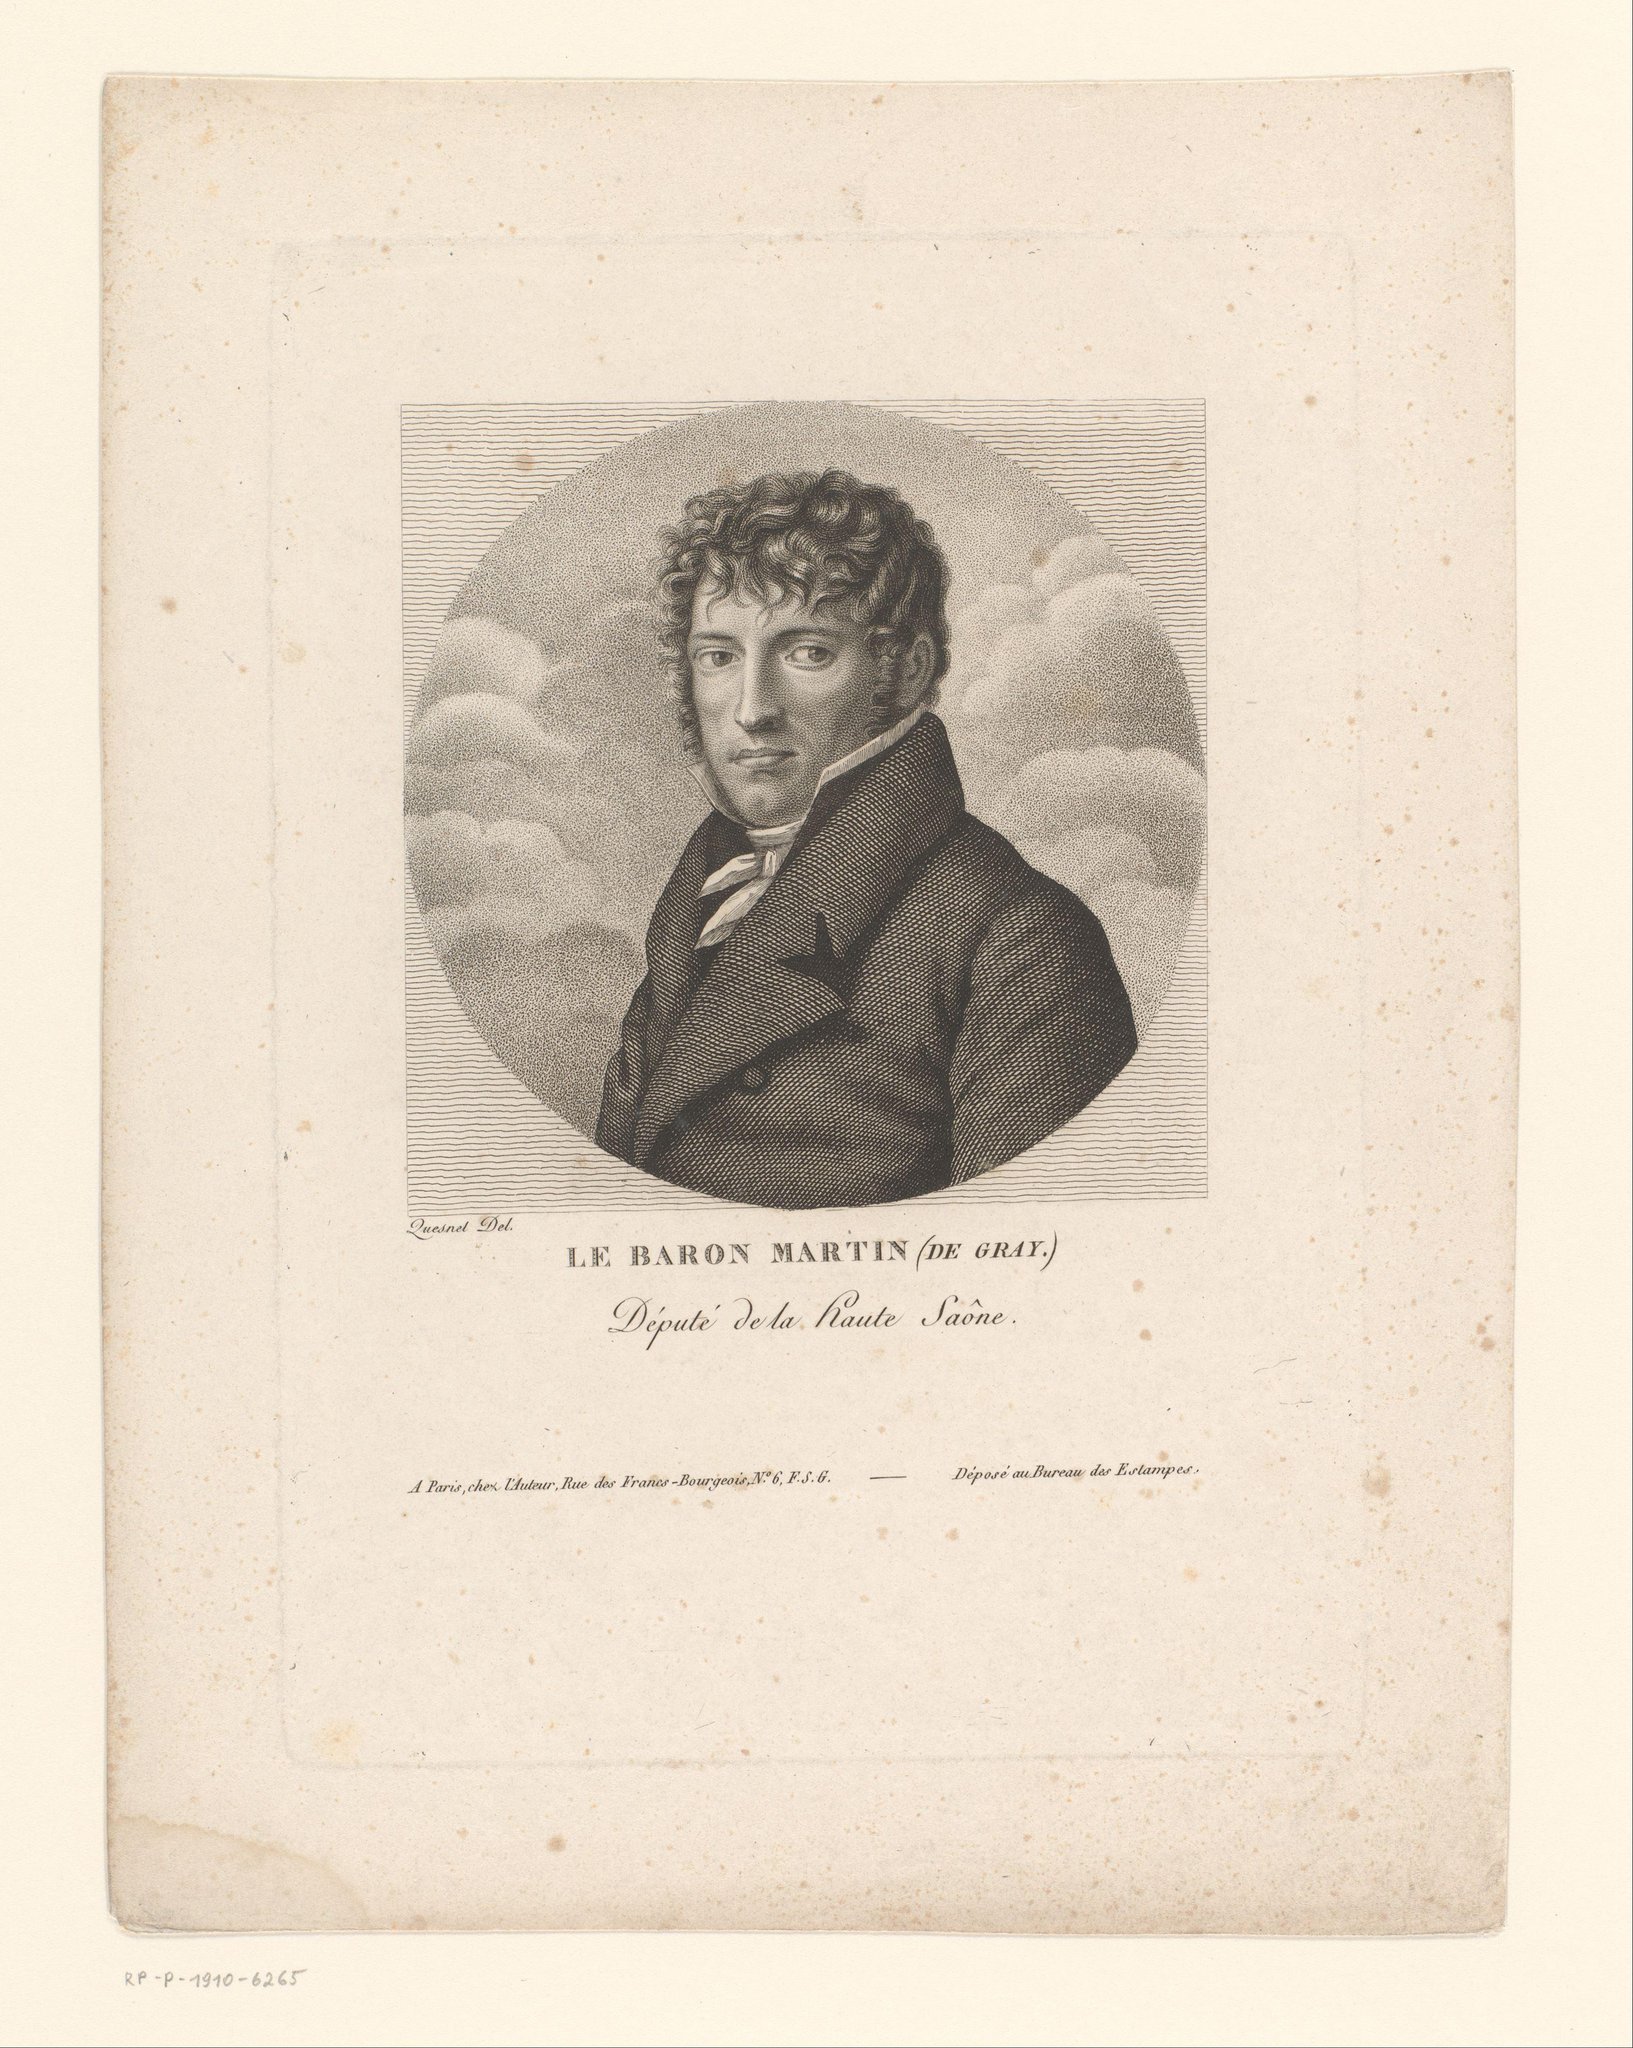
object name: print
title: Portret van Alexandre Martin de Gray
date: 1805-1850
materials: paper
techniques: engraving, etching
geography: france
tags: historical persons, politician, e.g. party leader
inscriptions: : ‘Déposé au Bureau des Estampes’, collector's mark: Lugt 2228